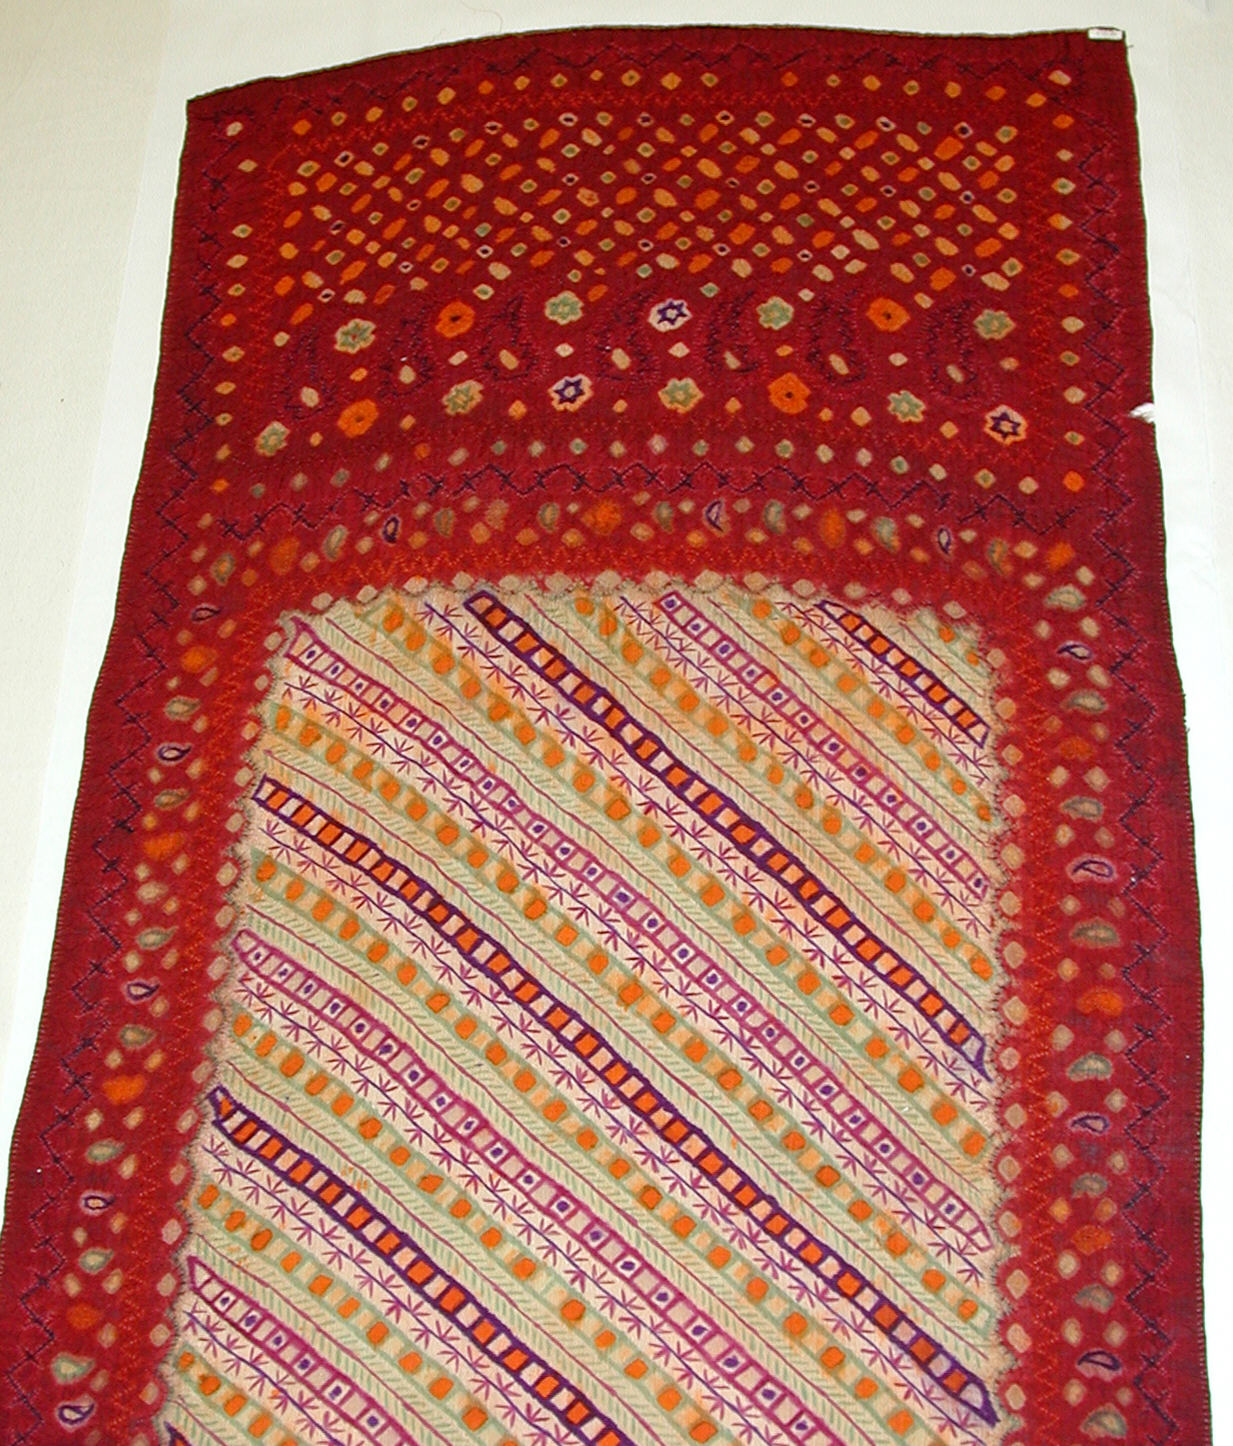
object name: panel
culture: sumatran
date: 1834-1933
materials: silk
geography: indonesia